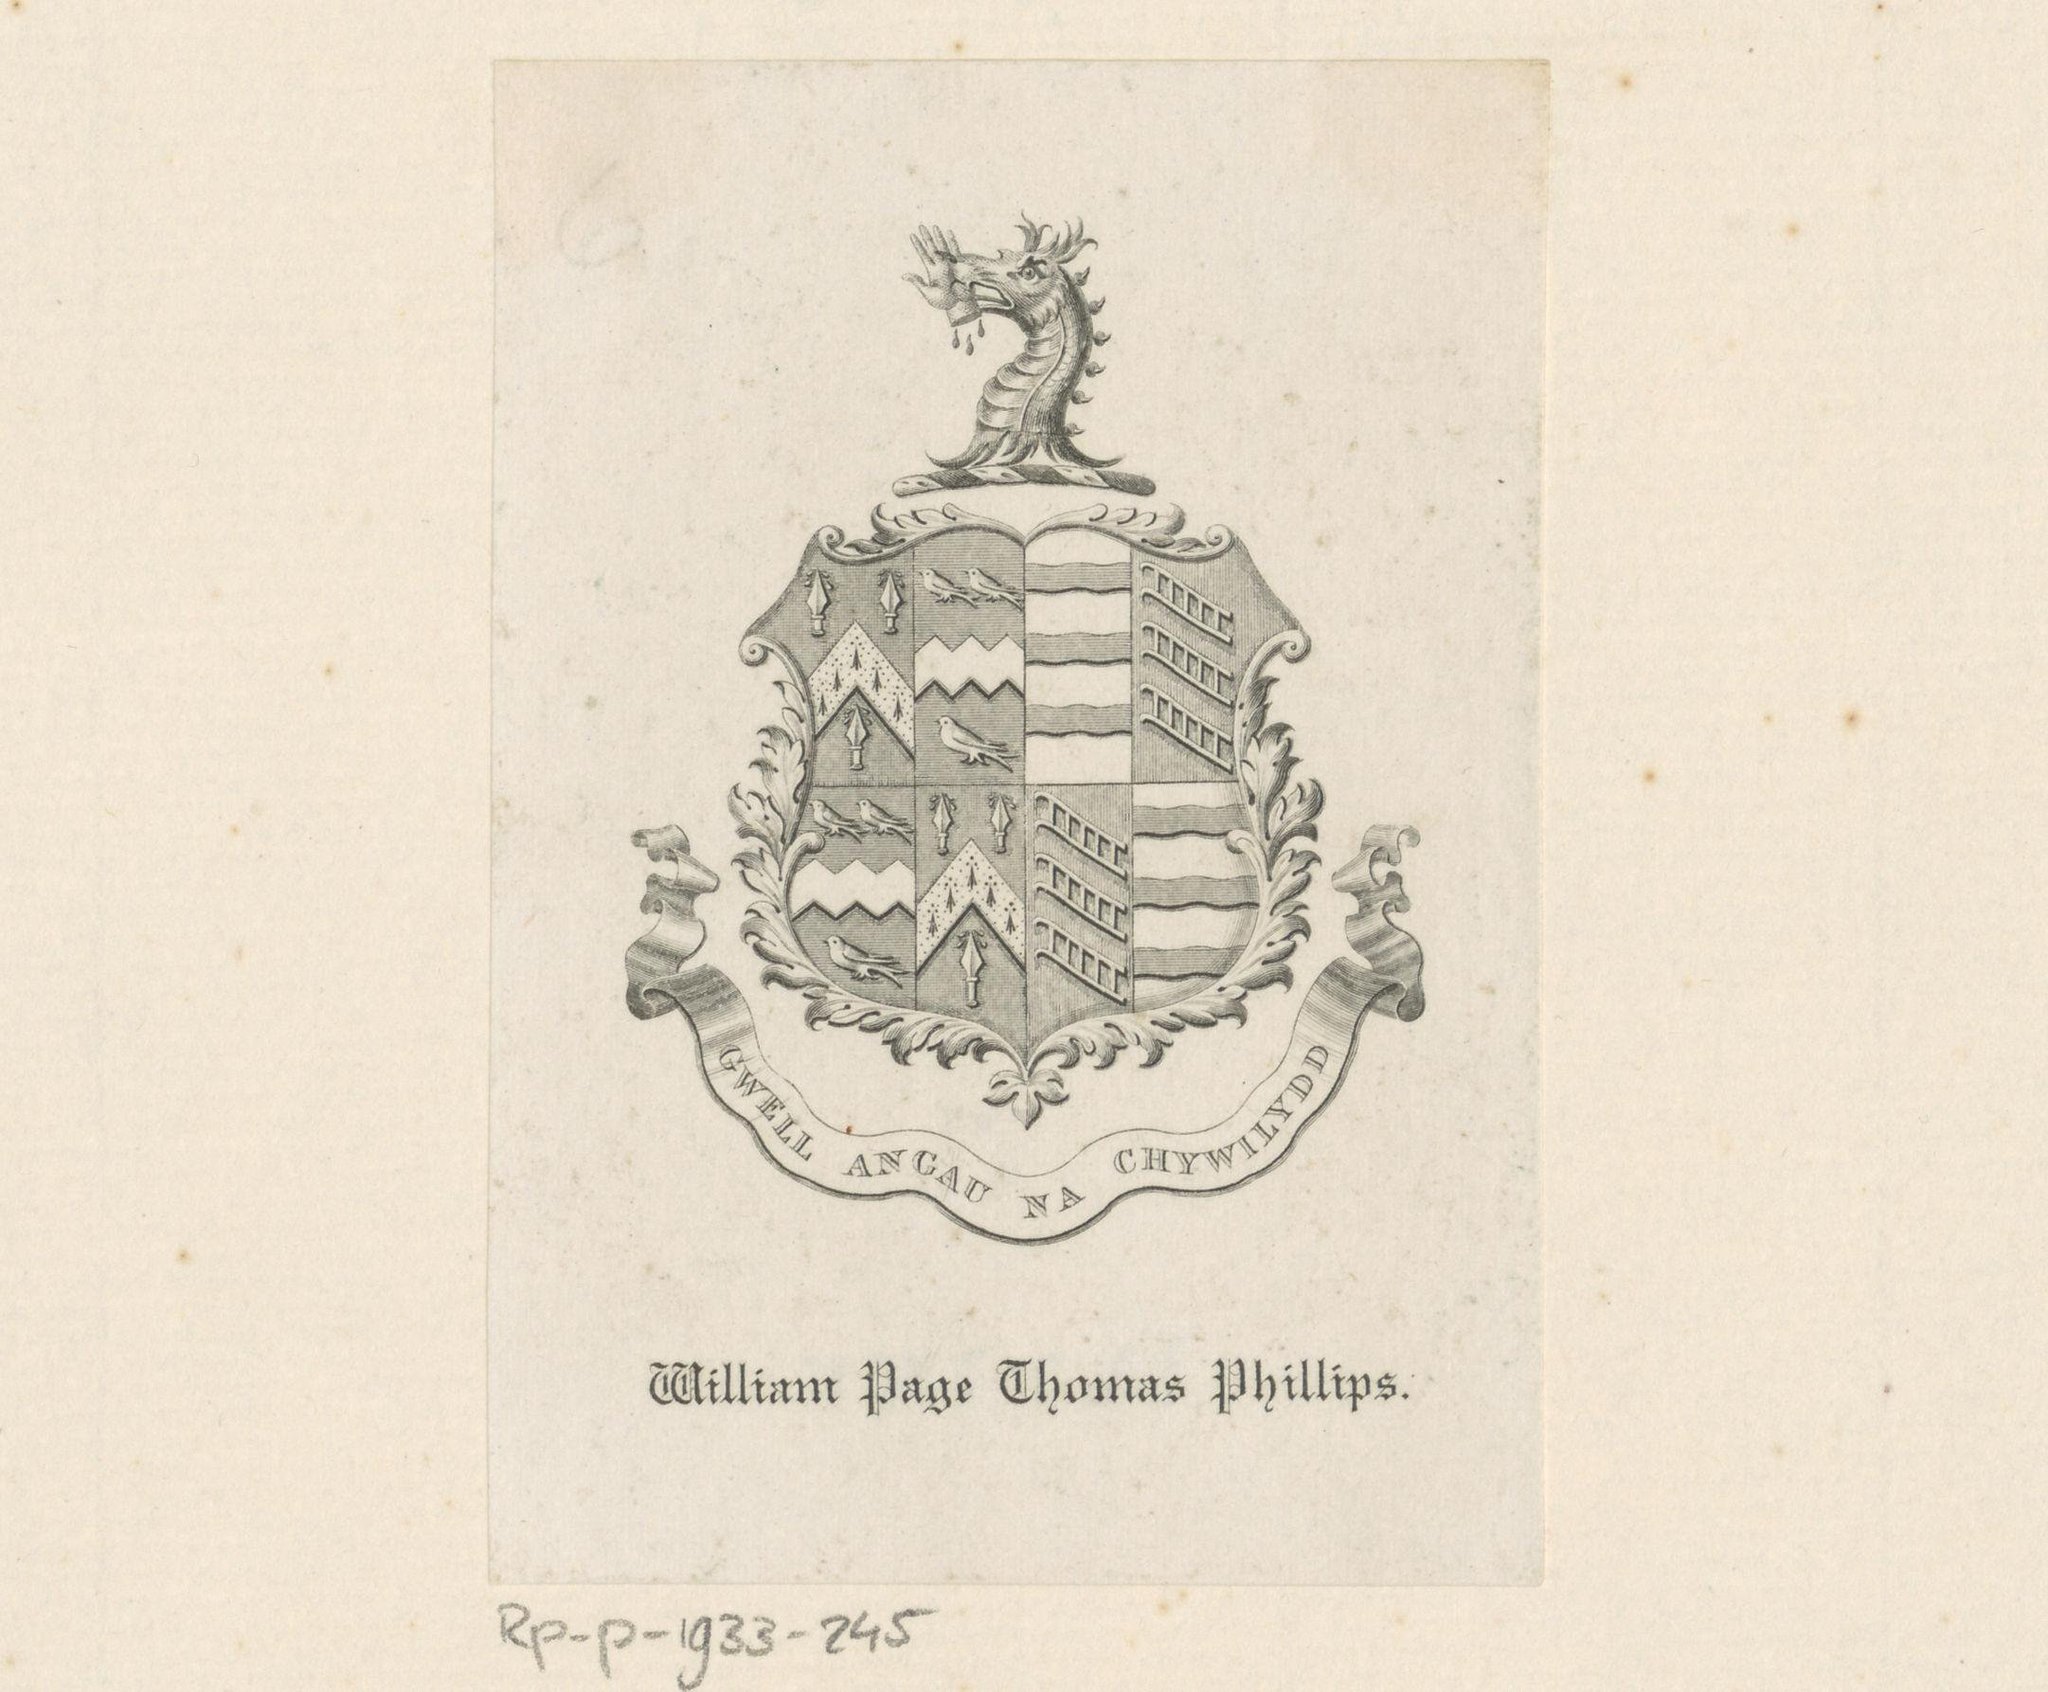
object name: bookplate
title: Ex libris van William Page Thomas Phillips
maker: Anonymous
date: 1800-1899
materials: paper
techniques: engraving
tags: armorial bearing, heraldry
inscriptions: collector's mark: Lugt 2760